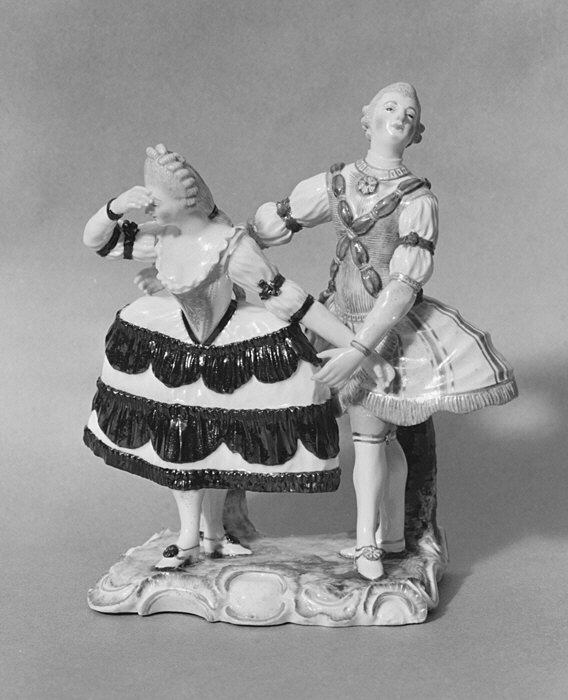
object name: group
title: Ballet dancers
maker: ludwigsburg porcelain manufactory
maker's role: manufactory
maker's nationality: german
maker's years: 1758-1824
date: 1760-1763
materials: hard paste porcelain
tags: men,women,dancers,ballet